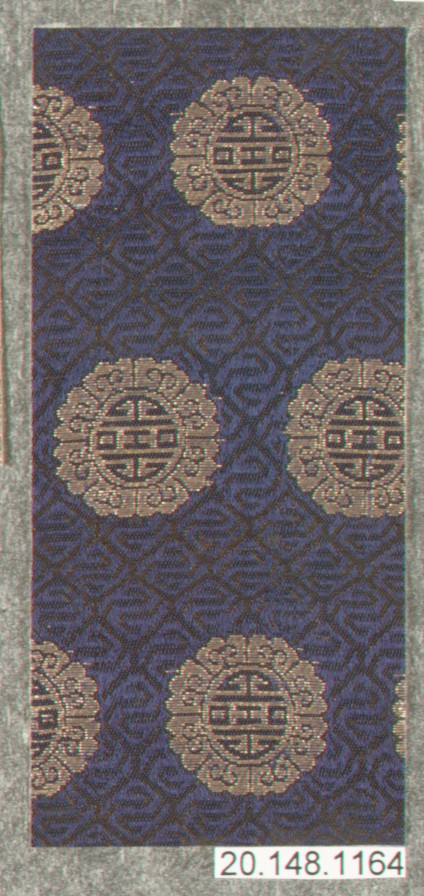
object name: piece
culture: japanese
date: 1801-1900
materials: silk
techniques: compound weave